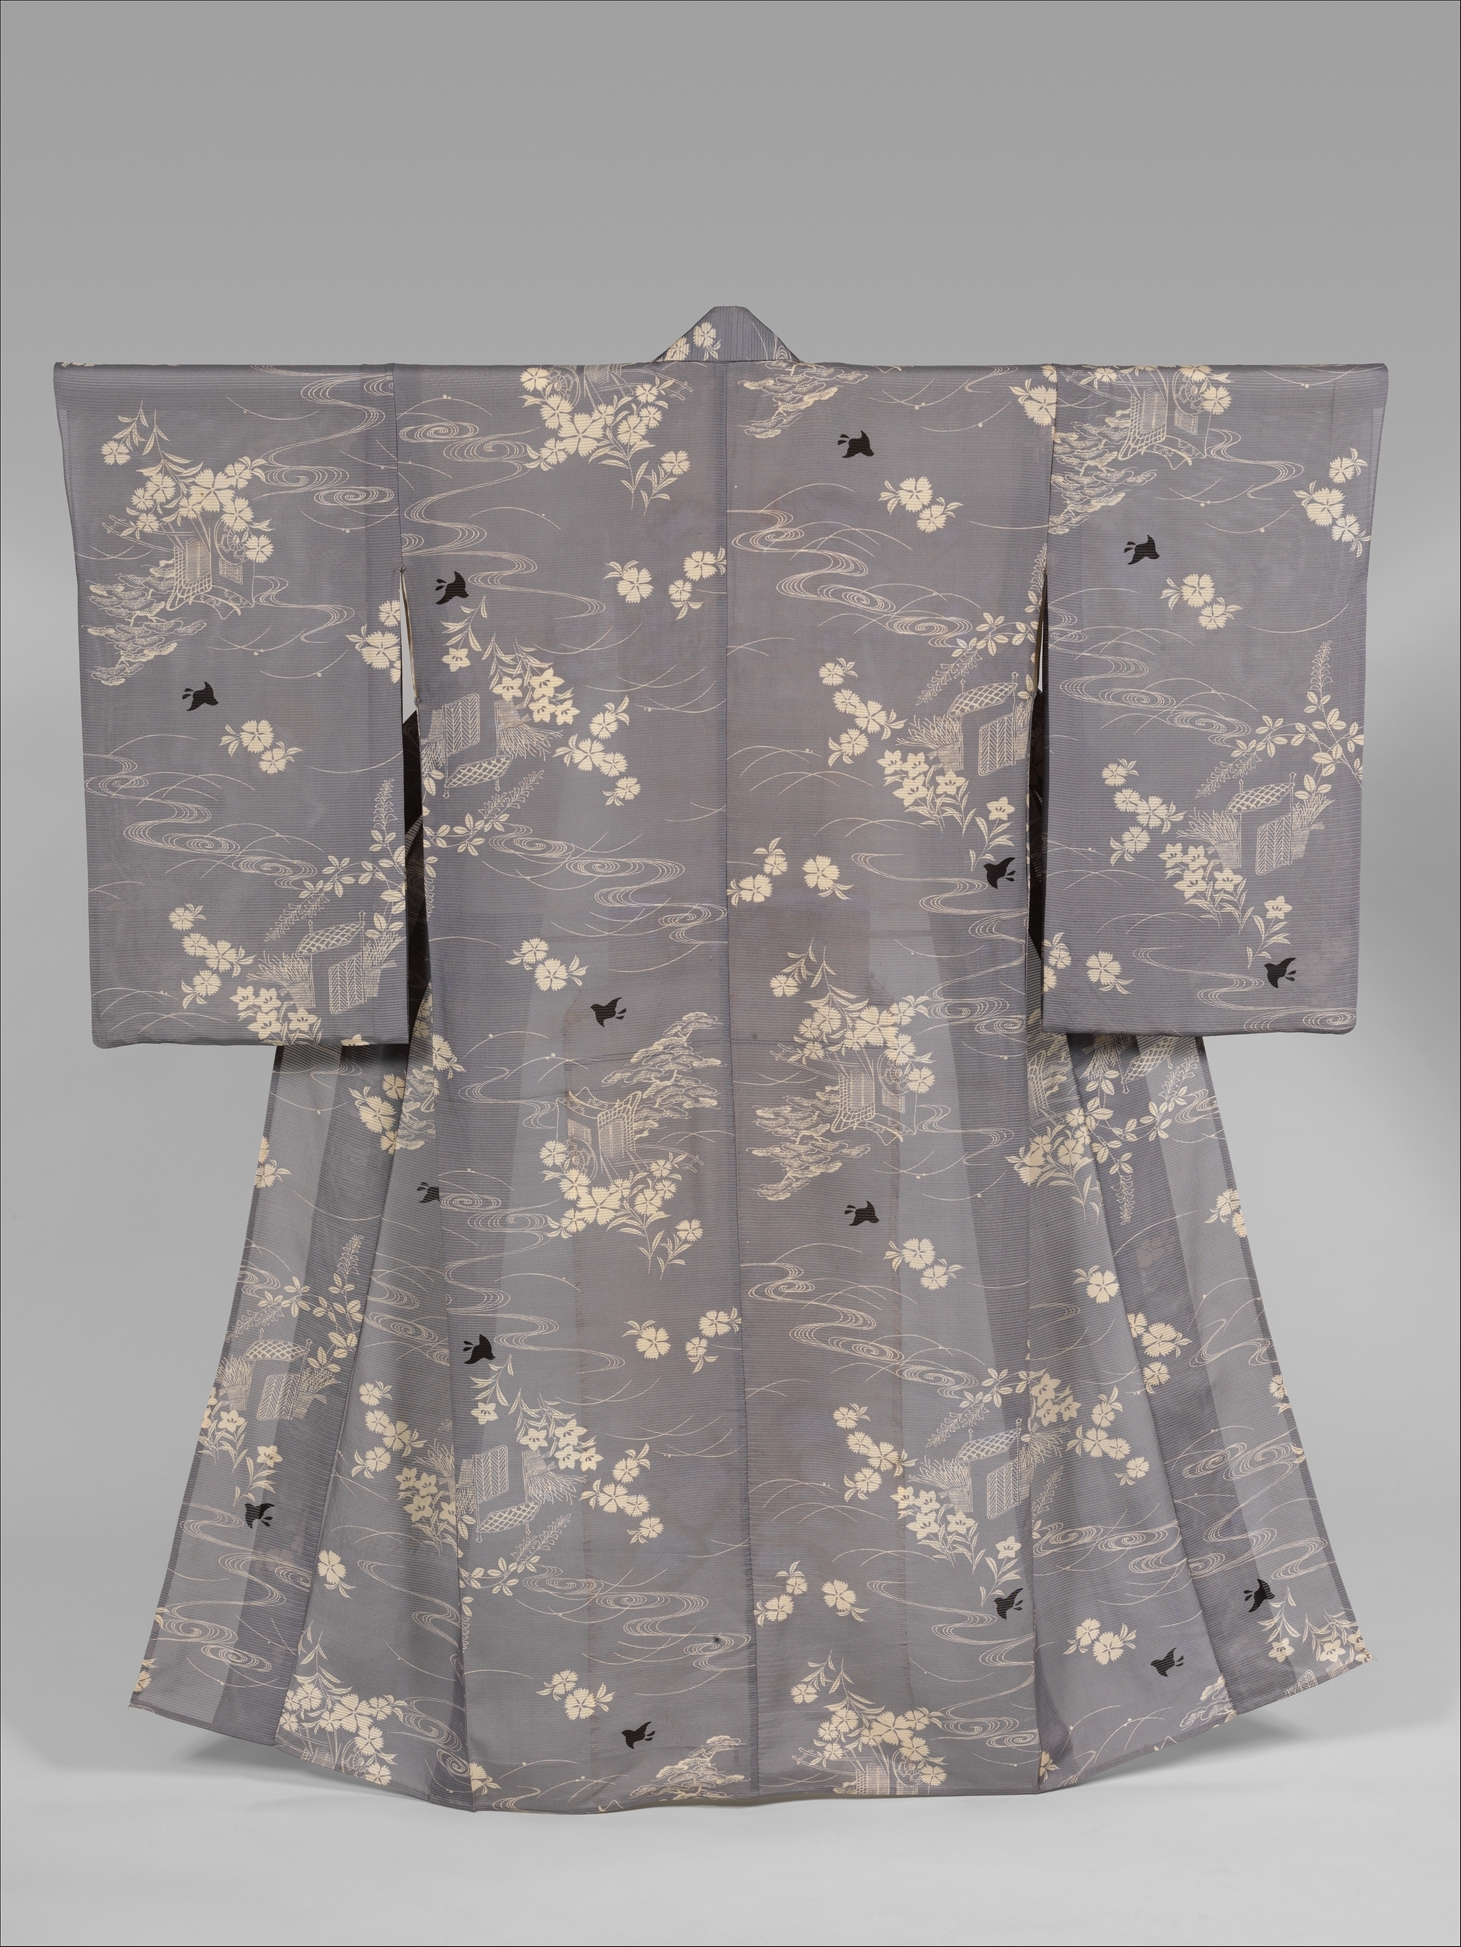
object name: kimono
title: Summer Kimono with Design of Plovers, Waves, Chinese Bellflowers, Pinks, Pines, Carriages, and Fences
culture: japanese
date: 1901-1925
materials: textile, paste, silk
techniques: resist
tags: birds,flowers,carriages